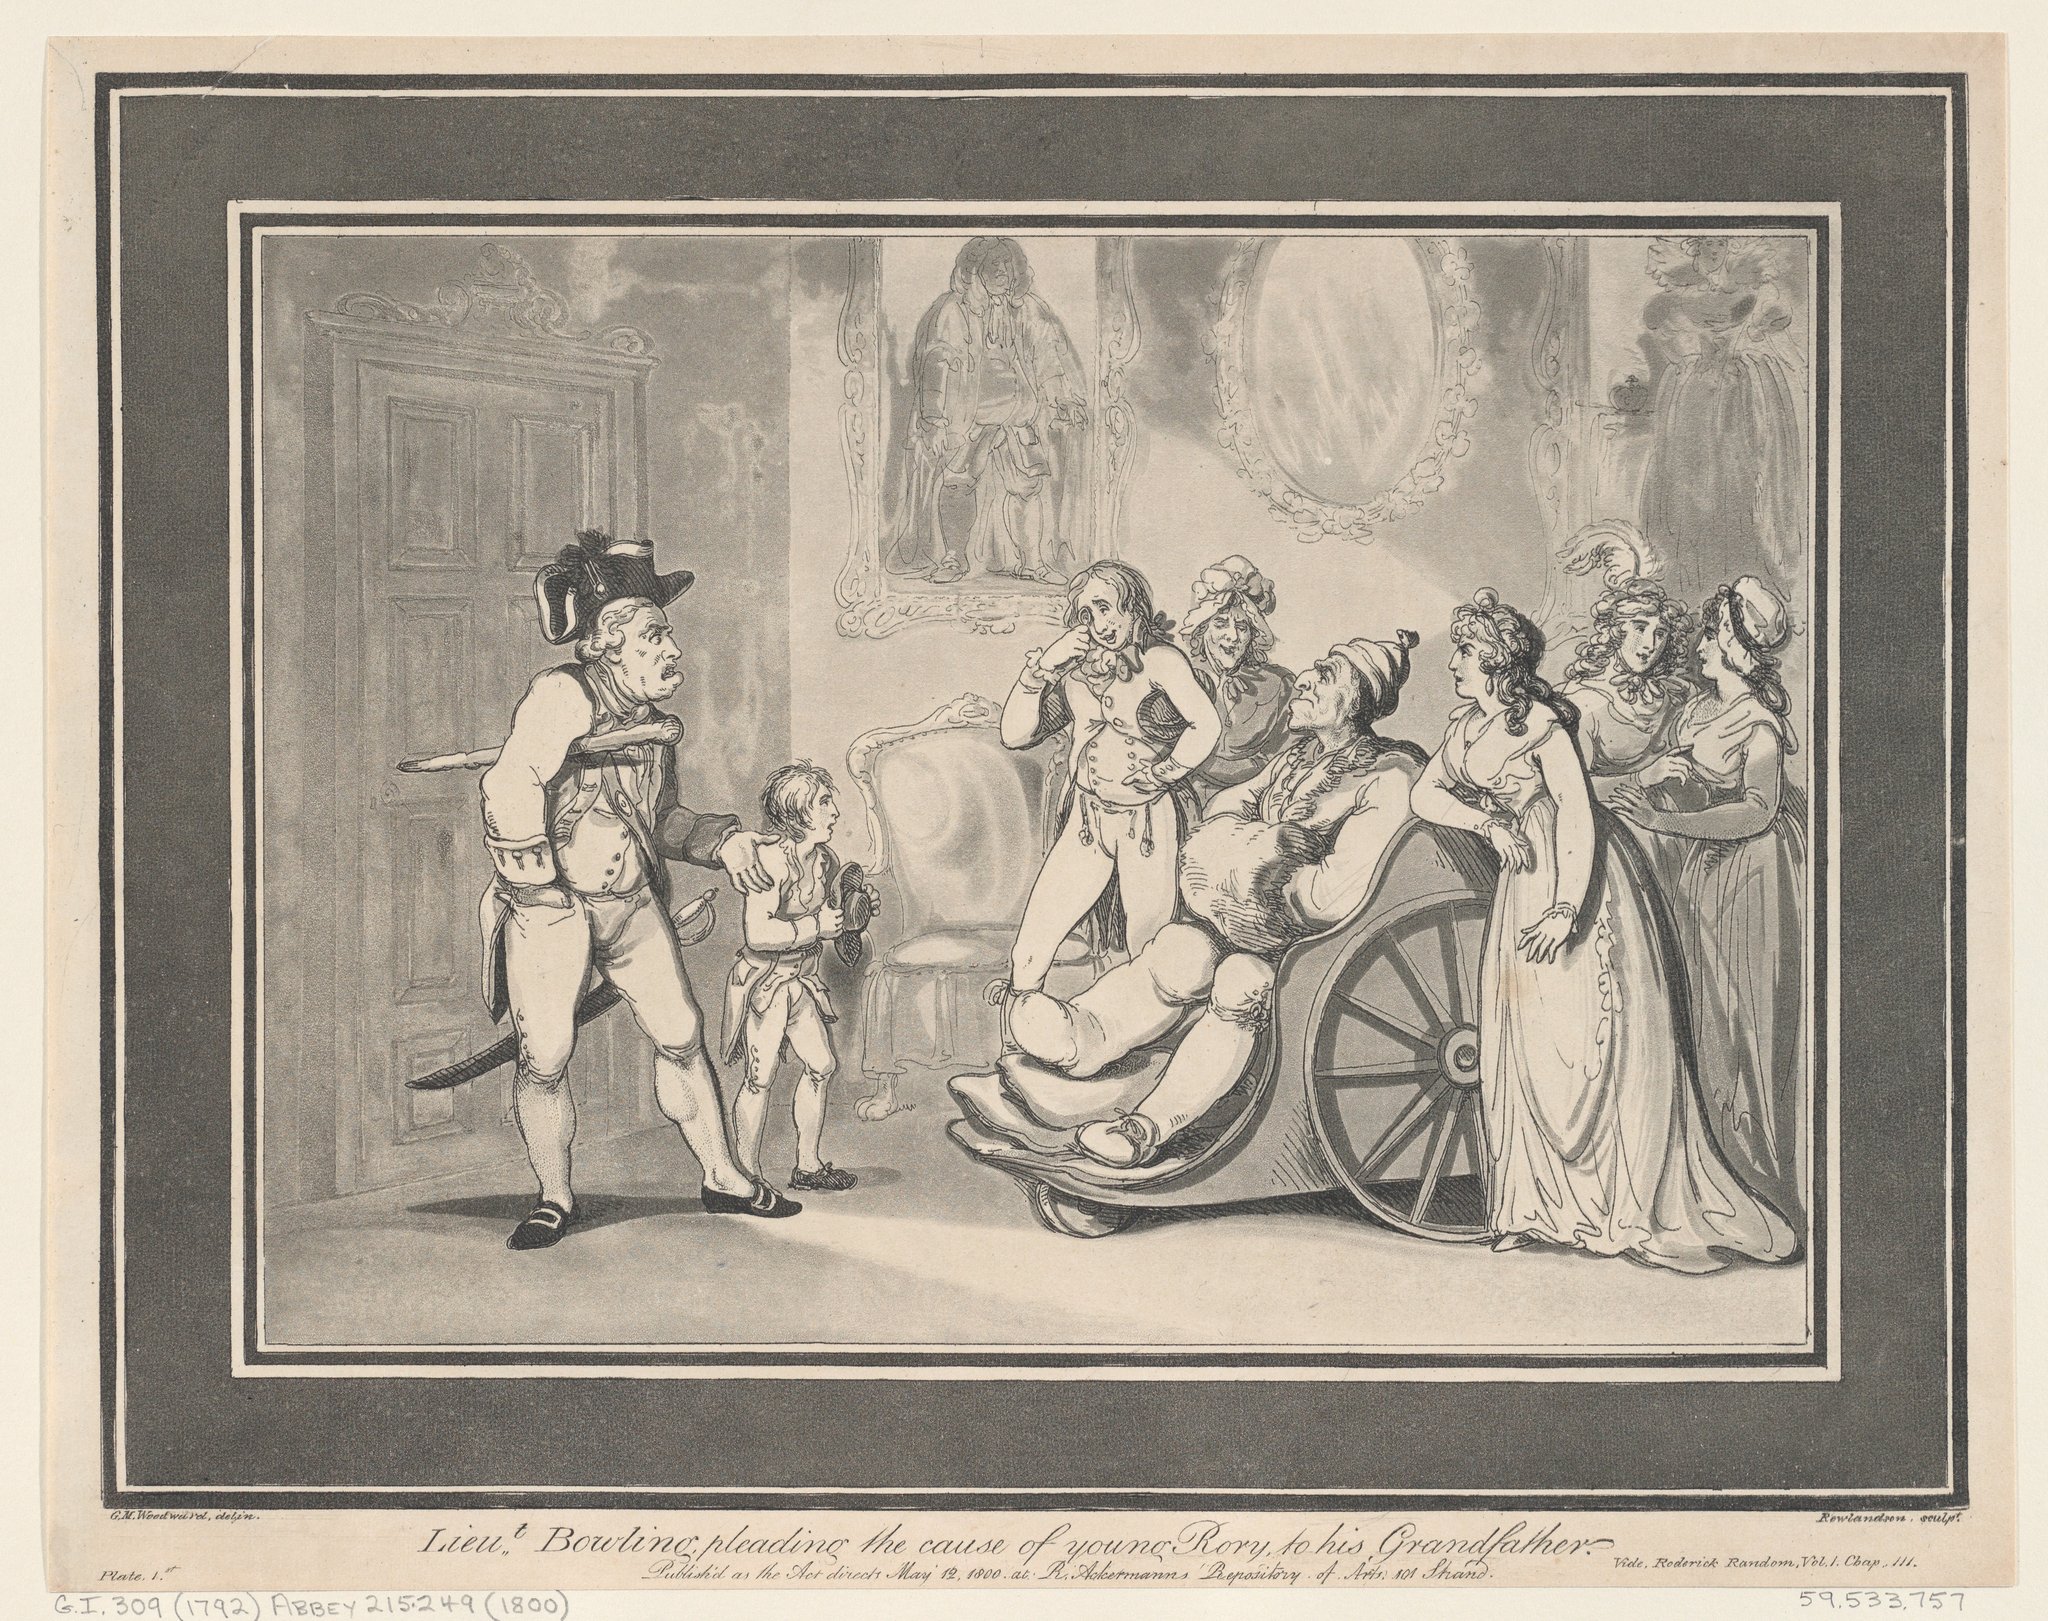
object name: print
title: Lieutenant Bowling pleading the cause of young Rory to his Grandfather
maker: thomas rowlandson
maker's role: artist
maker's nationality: british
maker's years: 1757-1827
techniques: aquatint, etching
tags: men